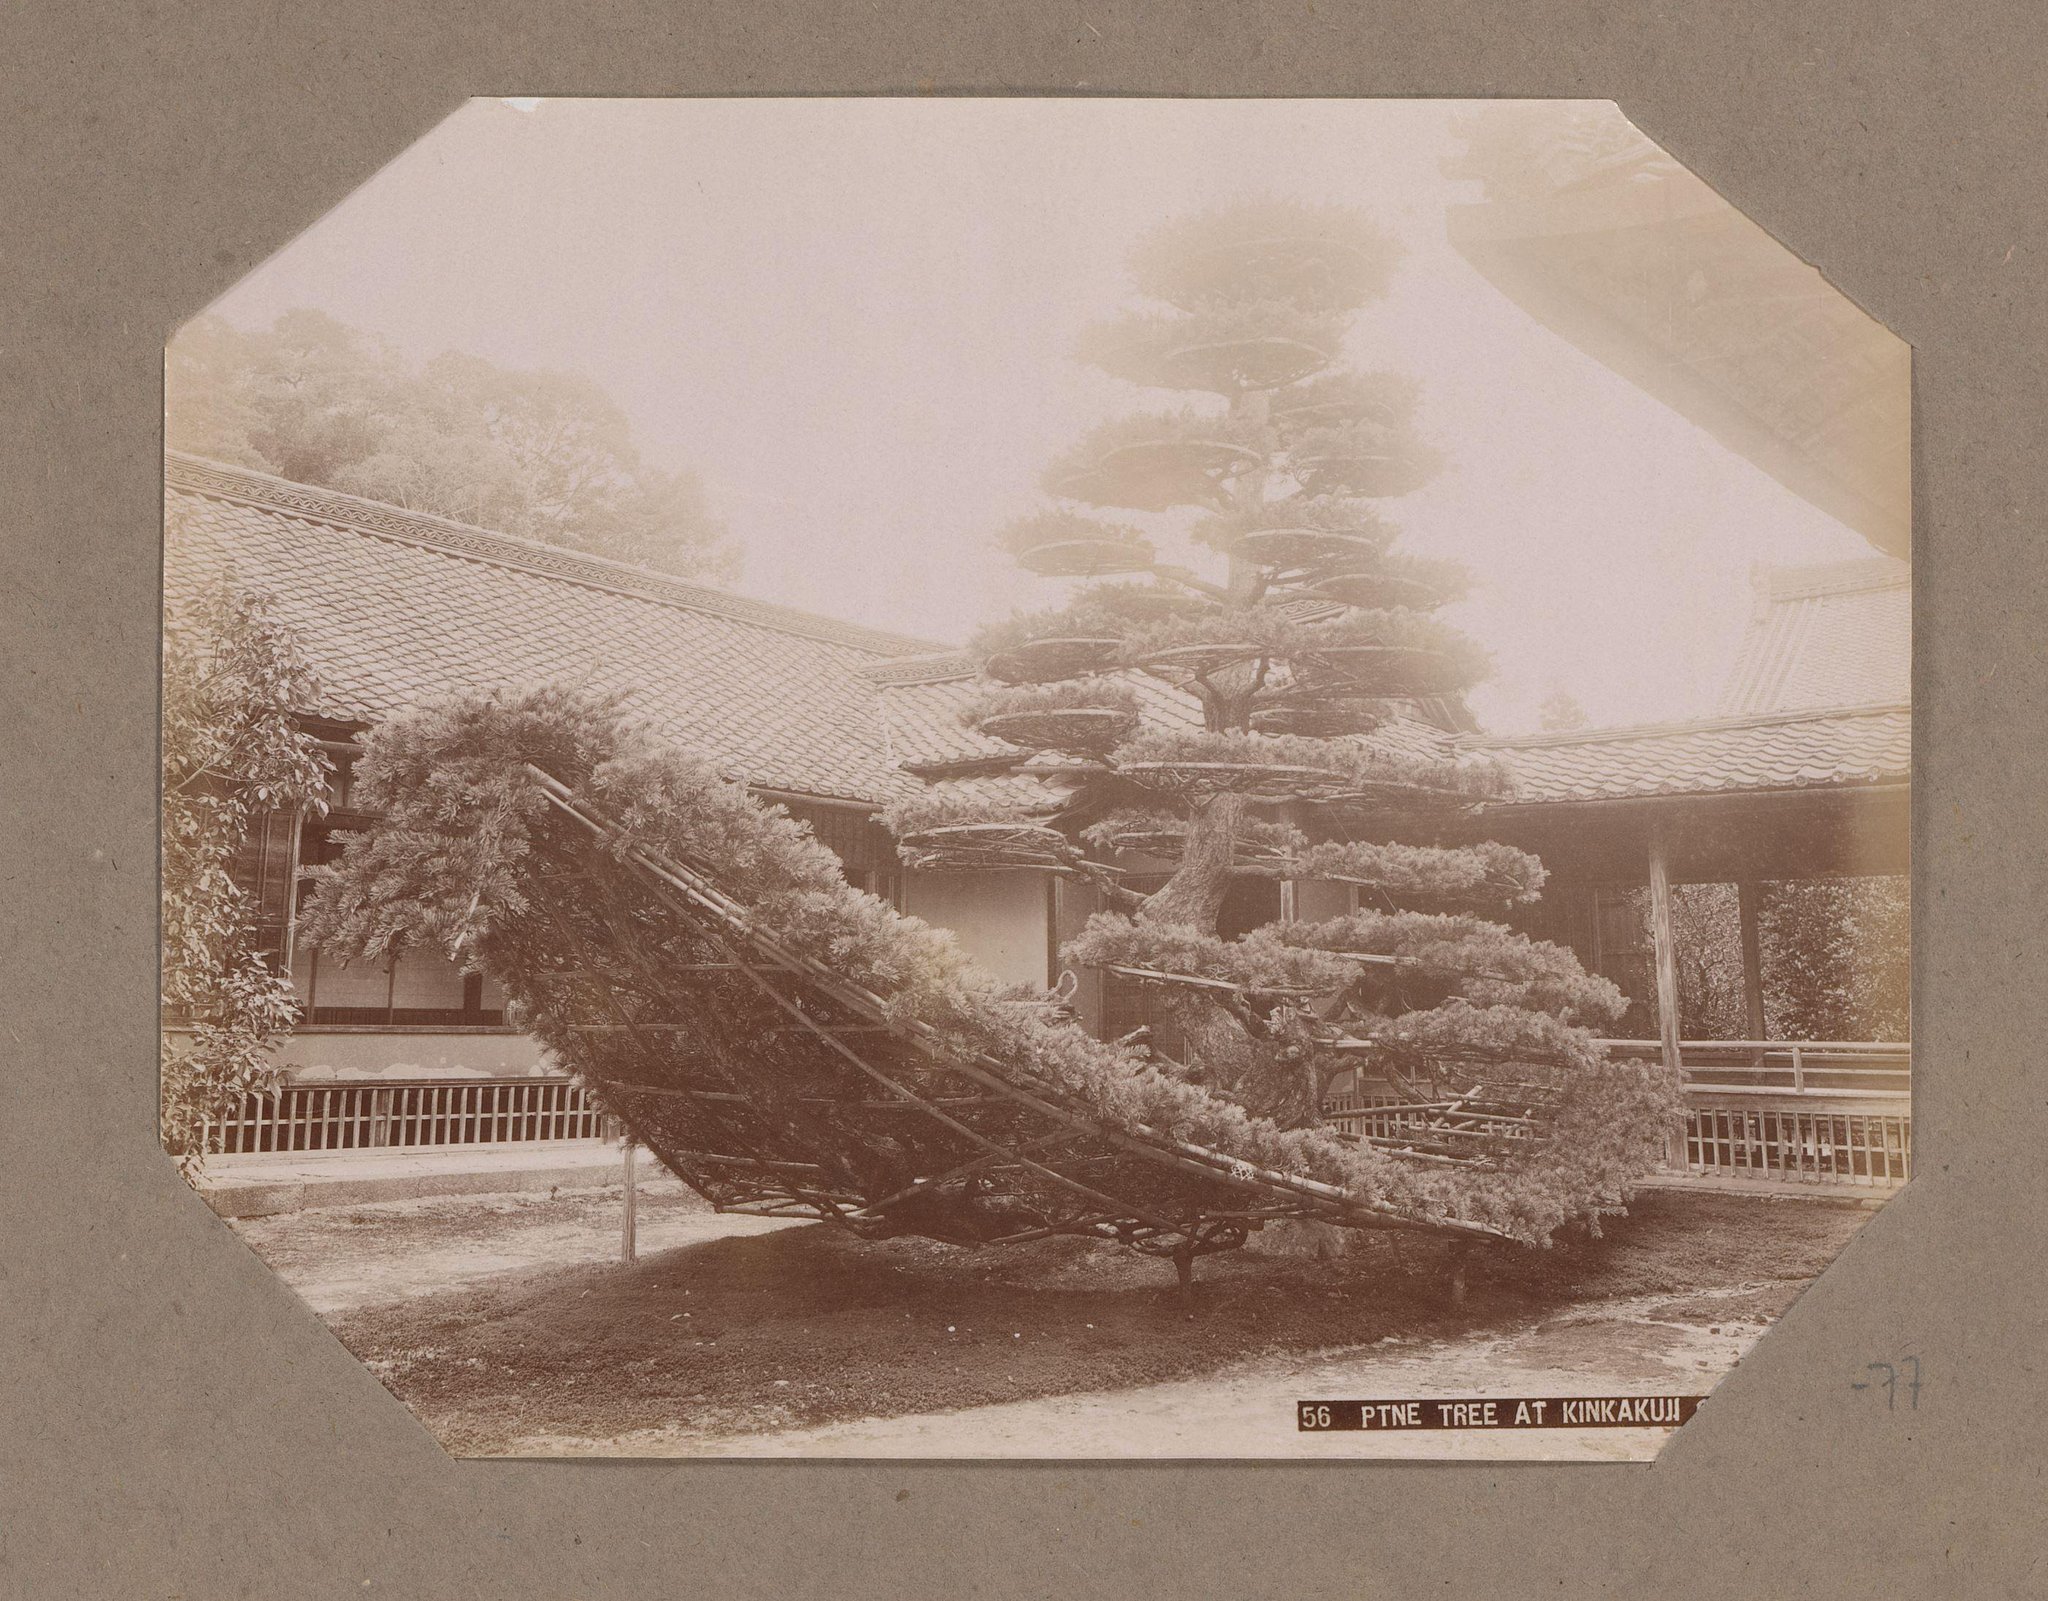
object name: album leaf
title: Dennenboom in de Kinkaku-ji tuin in Kyoto, Japan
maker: Anonymous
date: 1890-1903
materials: paper, photographic support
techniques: albumen print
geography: kyoto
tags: garden, trees: pine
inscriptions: inscription: ‘56 Ptne Tree at Kinkakuji Garden - Kioto’